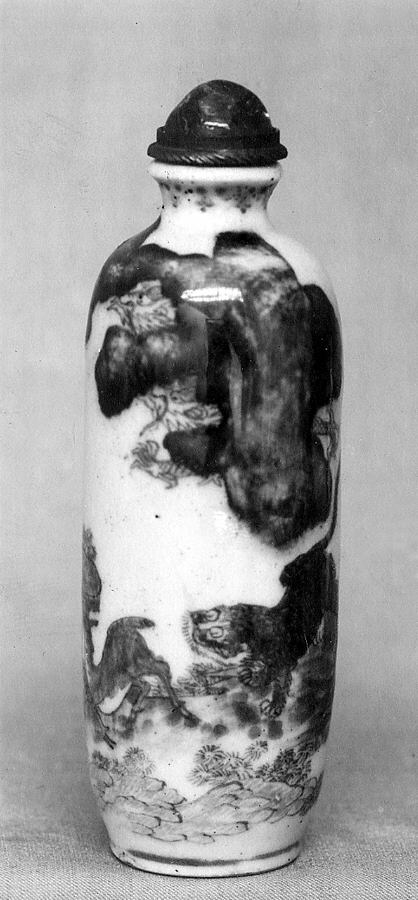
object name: snuff bottle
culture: chinese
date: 1801-1900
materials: porcelain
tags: dragons